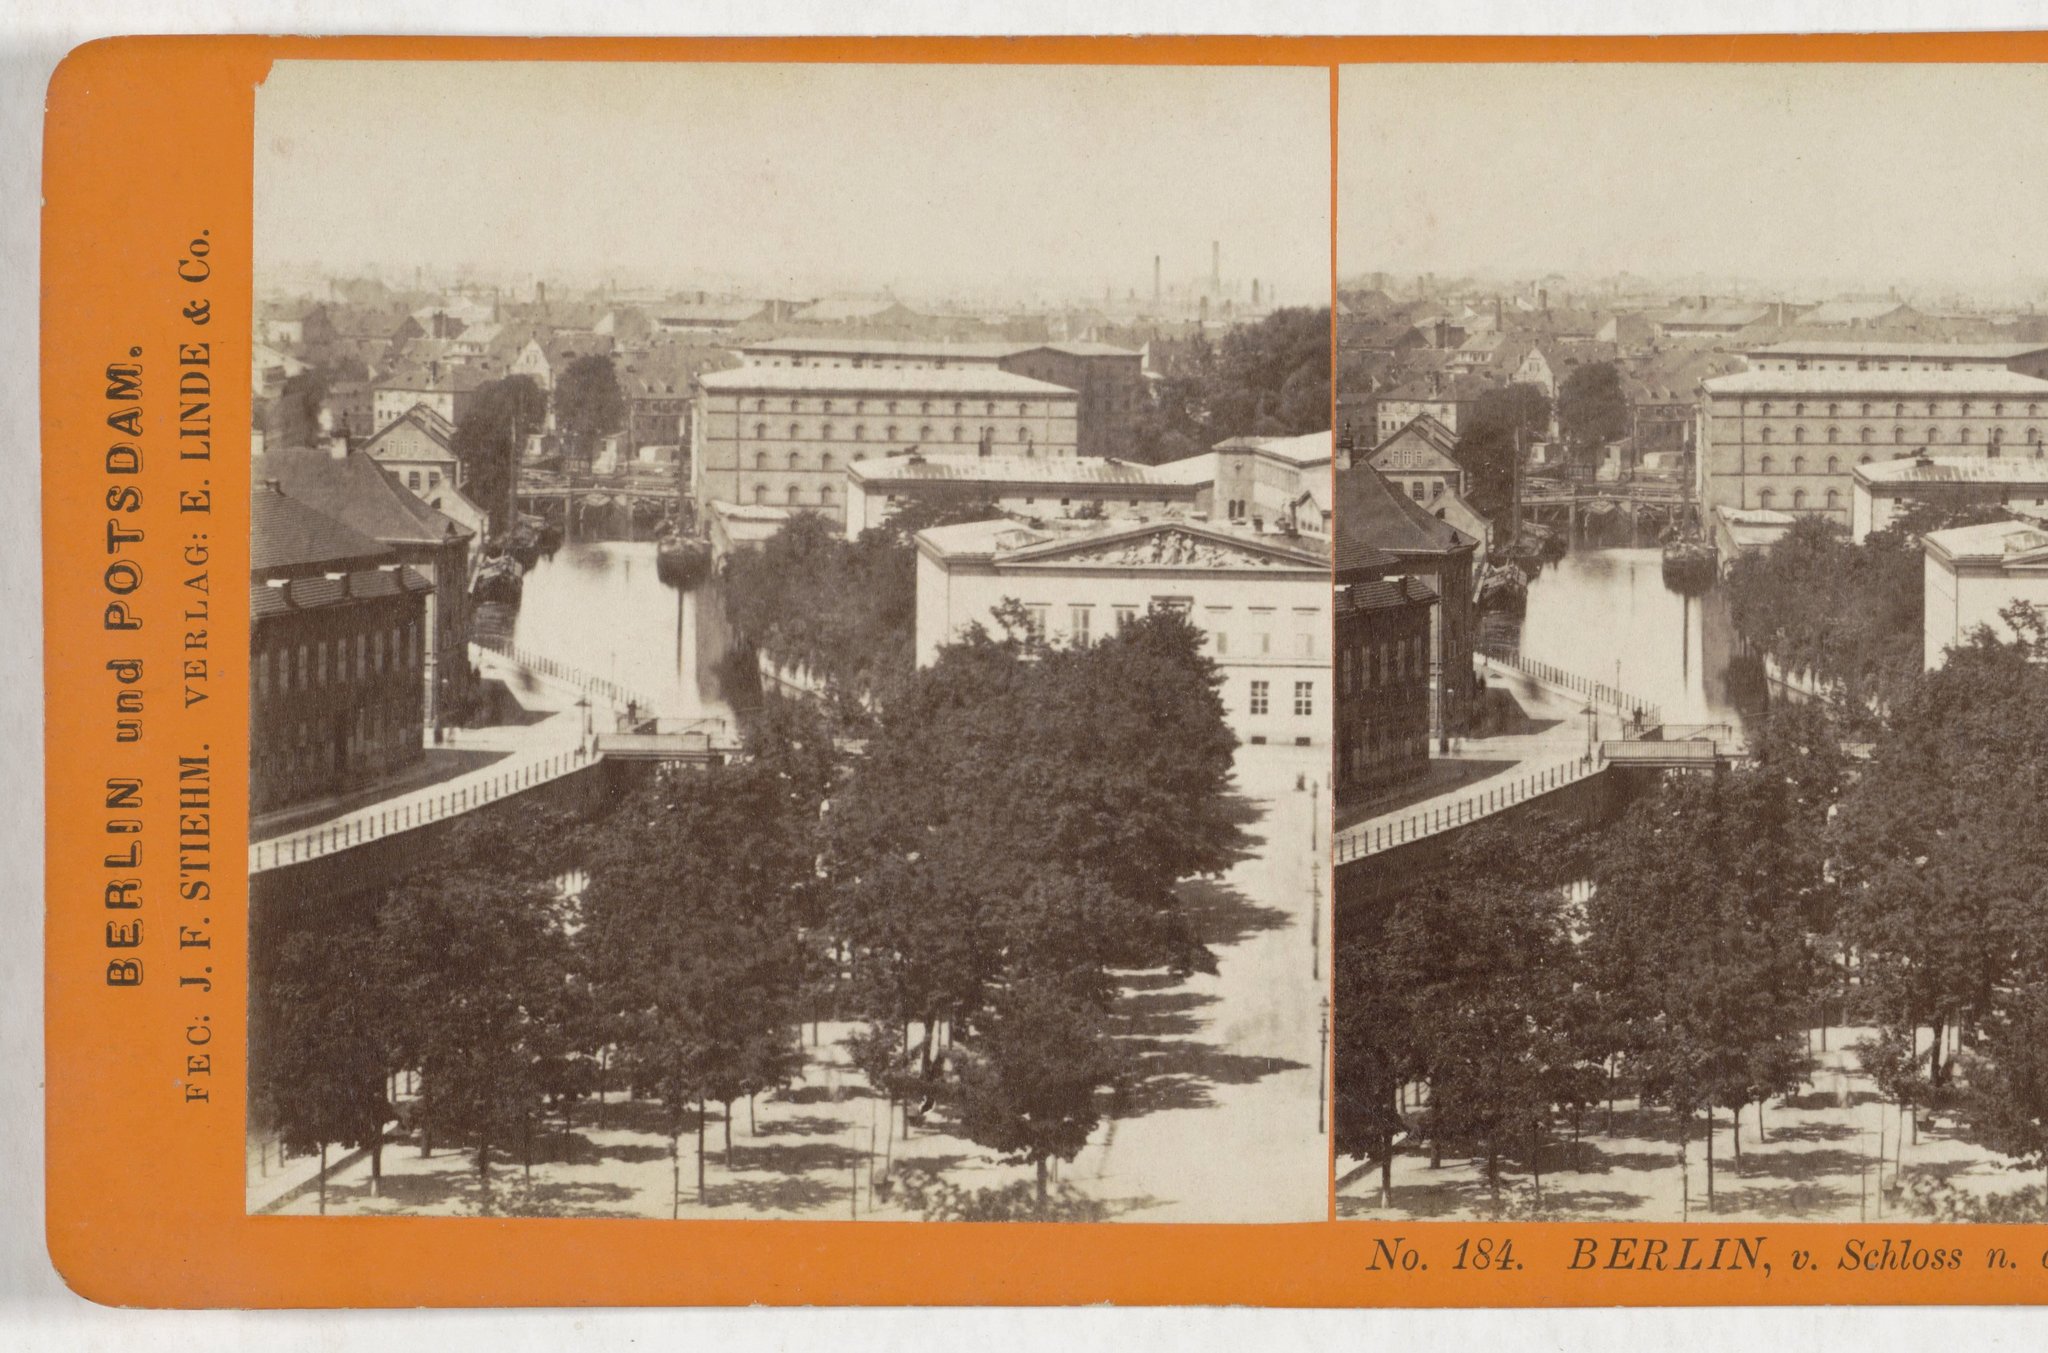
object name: stereograph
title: Ansichten von Deutschland / Berlin und Potsdam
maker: johann friedrich stiehm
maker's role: fotograaf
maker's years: 1826-1902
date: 1868-1870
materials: cardboard, paper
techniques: albumen print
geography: berlin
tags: city-view in general; 'veduta', canals, waters (in city), berlin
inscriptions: number: ‘No. 184.’